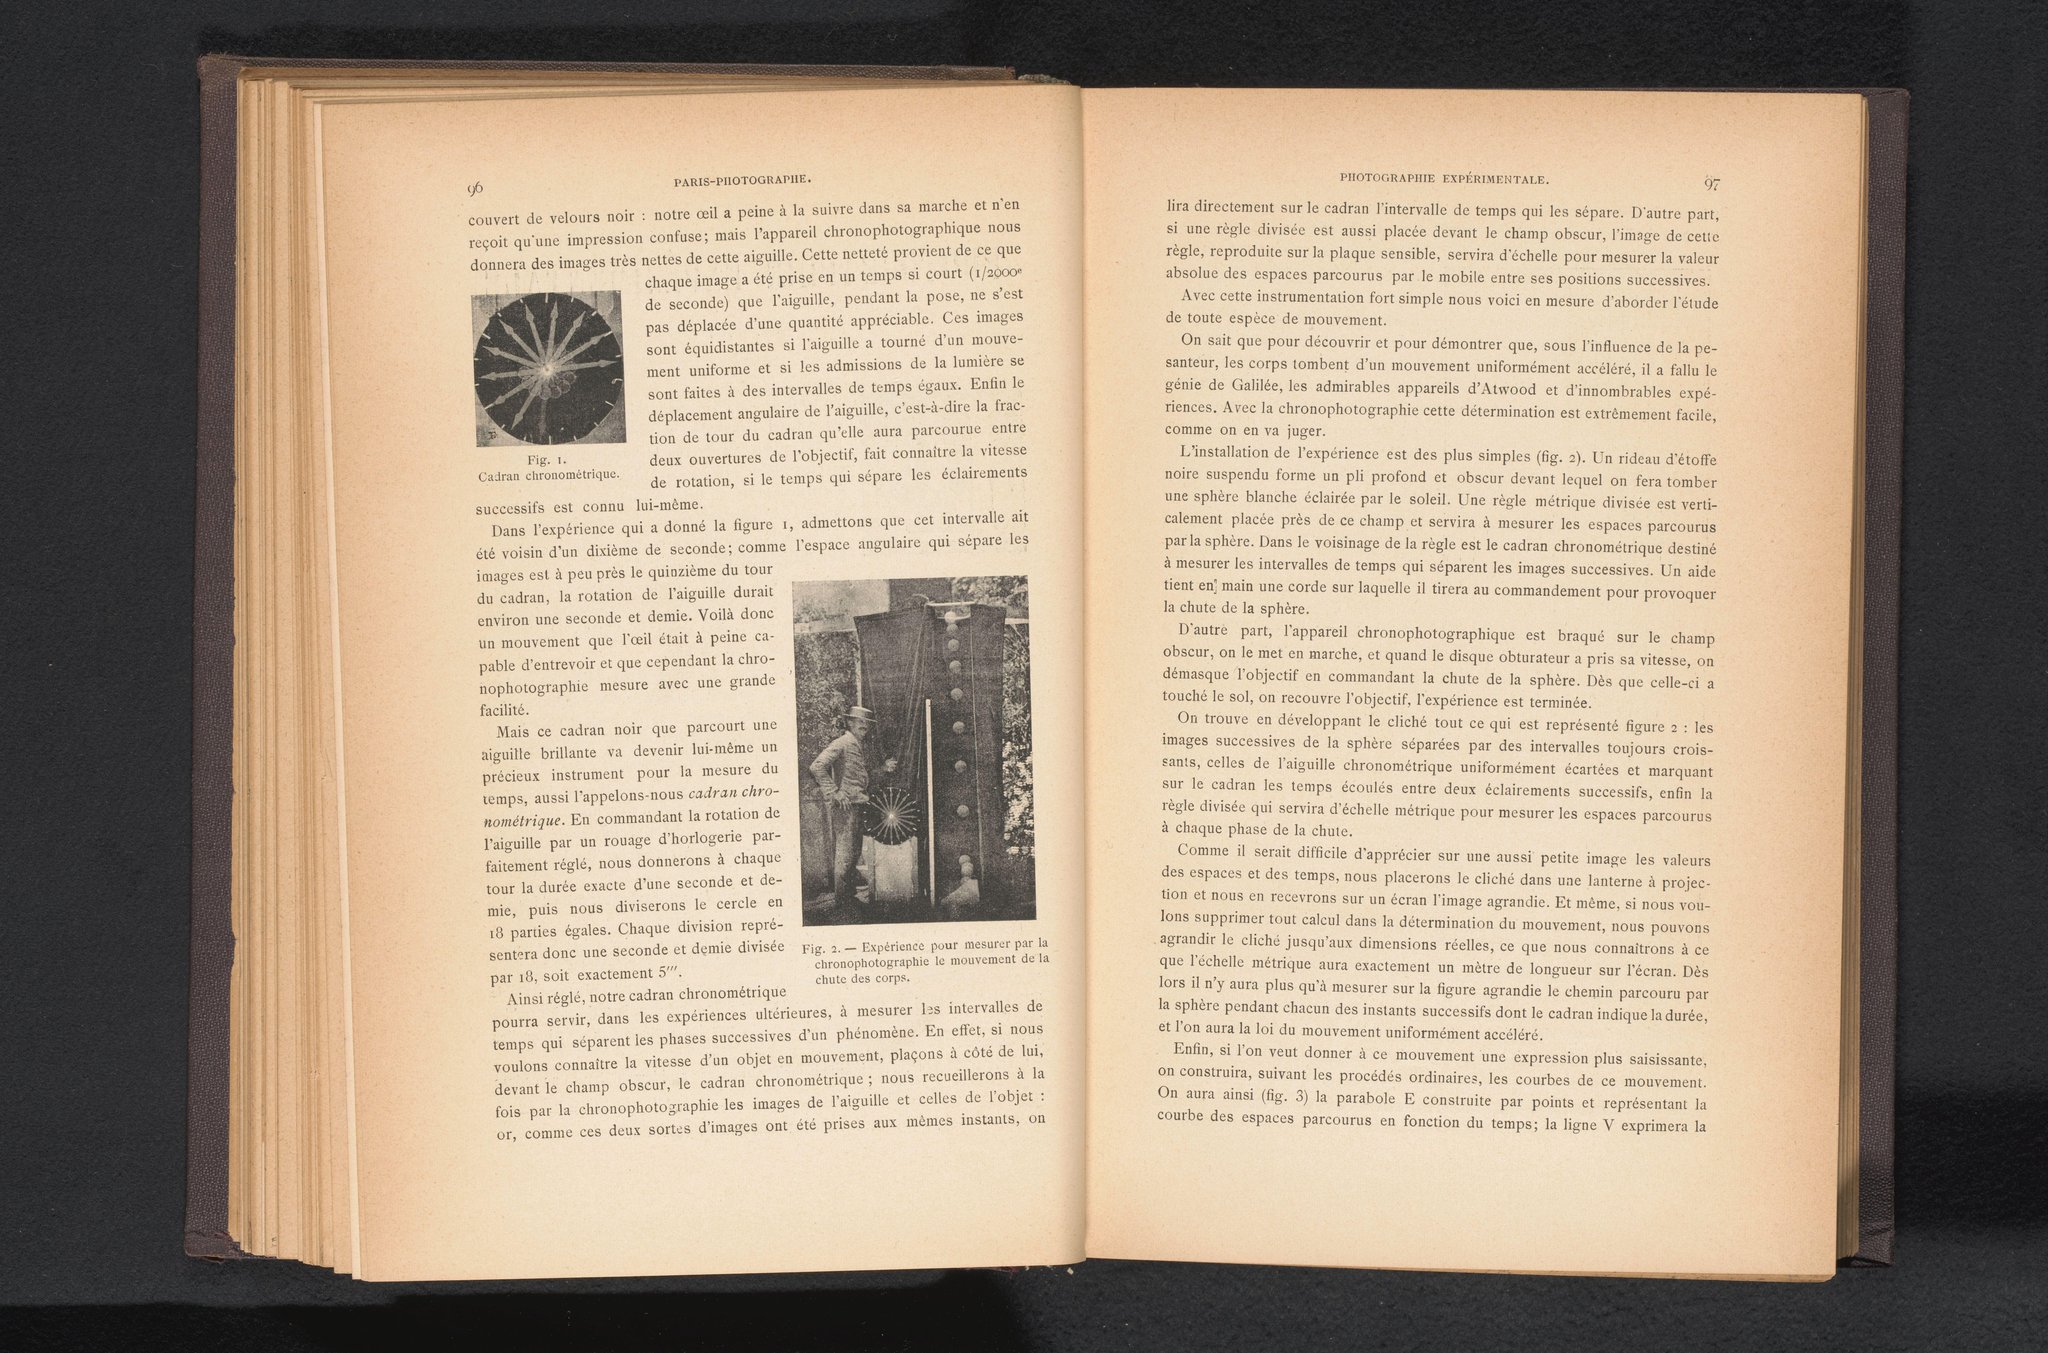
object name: photomechanical print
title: Cadran chronométrique. Expèrience pour mesurer par la chronophotographie le mouvement de la chute des corps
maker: Anonymous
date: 1883-1893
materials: paper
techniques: autotype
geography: france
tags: first beginnings of photography and cinematography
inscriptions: number: ‘Fig. 1. Fig. 2.’